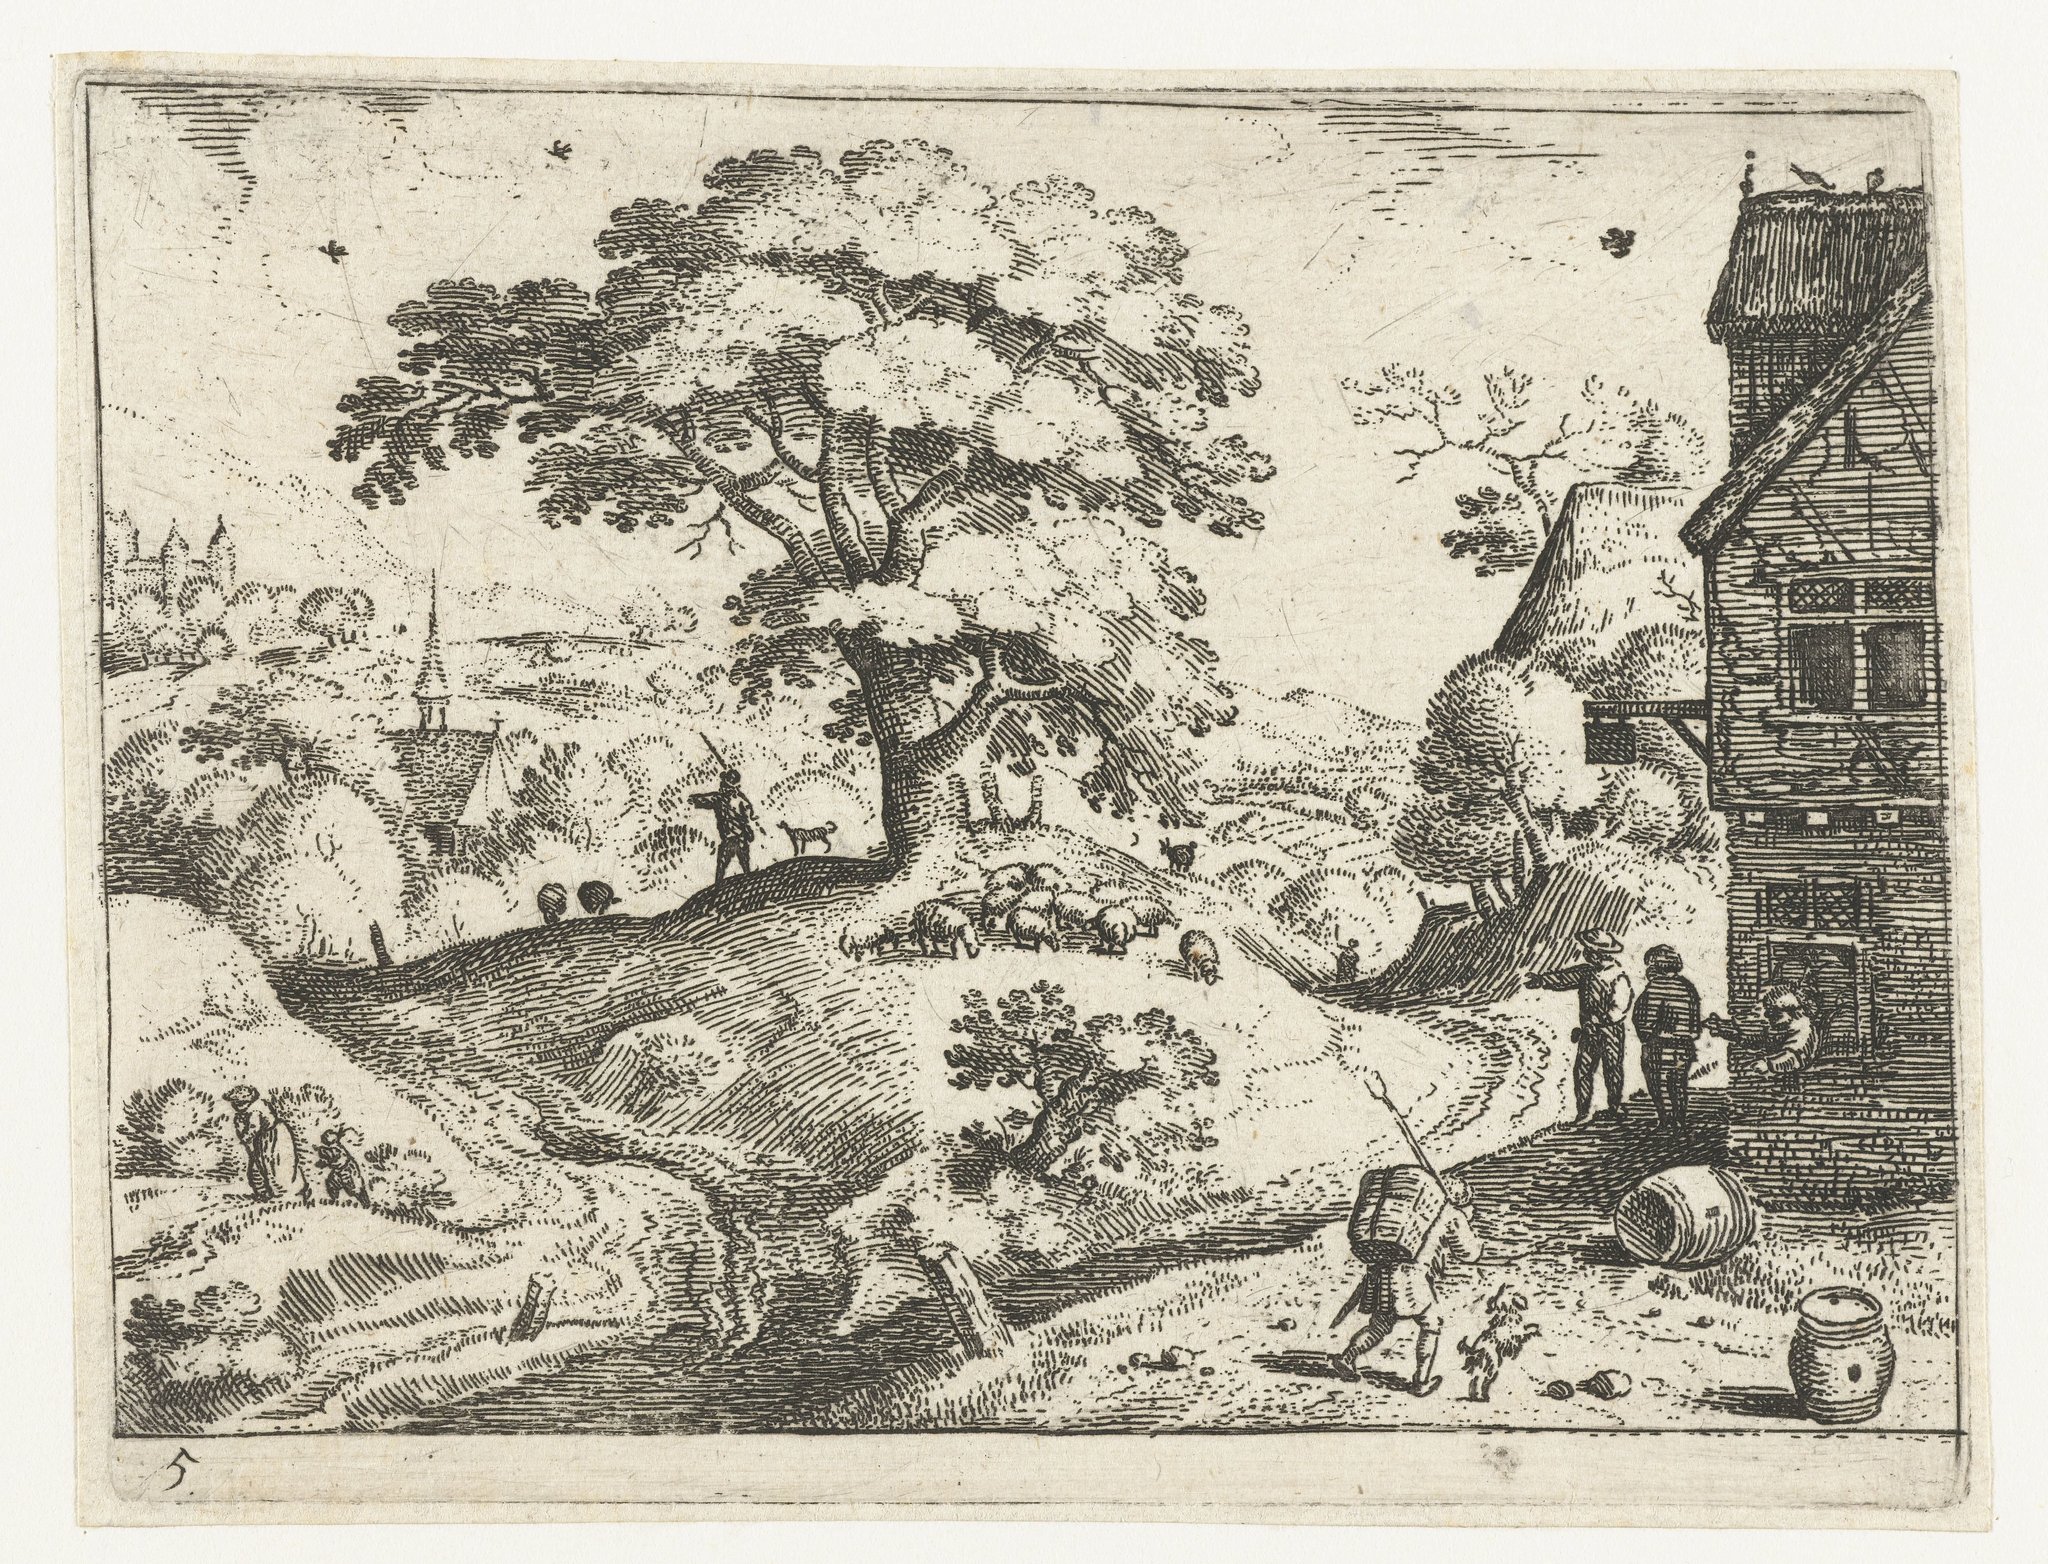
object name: print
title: Landschap met reiziger bij herberg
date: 1584-1603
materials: paper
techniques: etching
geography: netherlands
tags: landscapes in the temperate zone, 'en route', traveller under way, hotel, hostelry, inn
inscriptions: collector's mark: Lugt 2228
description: In een glooiend landschap loopt een reiziger (een man met een mand op zijn rug) met een hond naar een herberg. Deze prent is onderdeel van een serie van zes landschappen met reizigers.